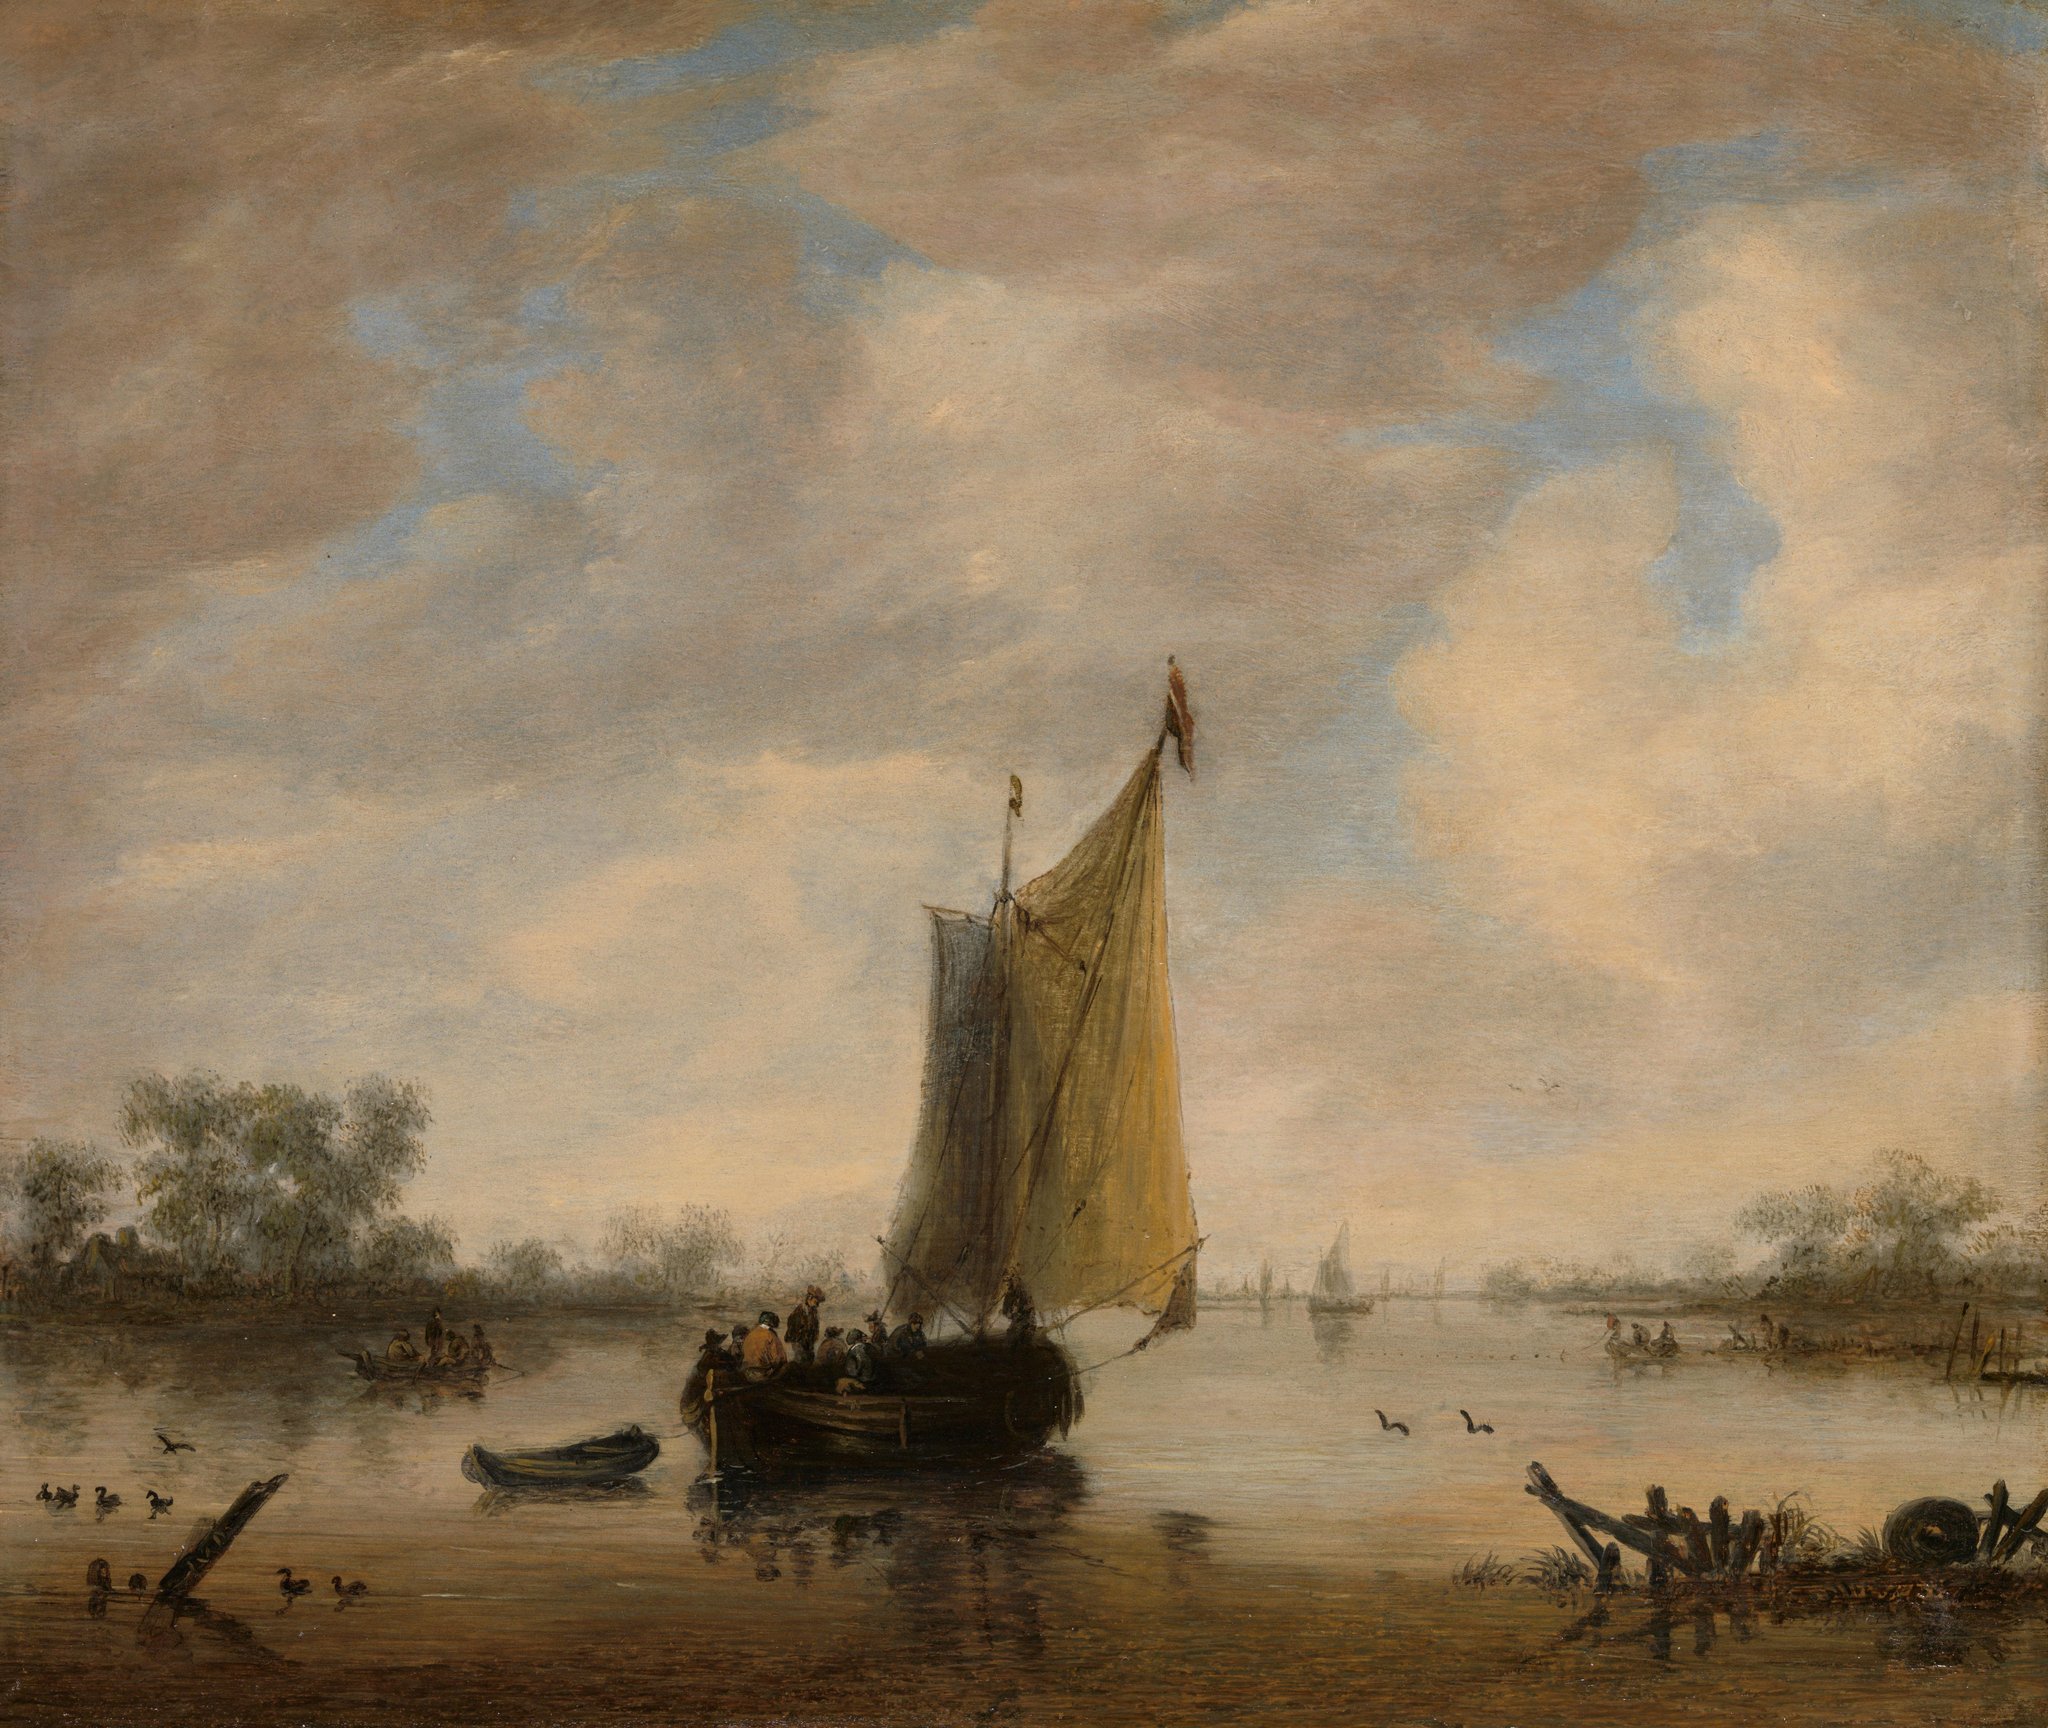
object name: painting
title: River View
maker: jeronymus van diest (ii)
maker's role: painter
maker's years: 1631-1677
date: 1650-1675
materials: oil, panel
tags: ferry, river (+ landscape with figures, staffage)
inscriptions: signature: ‘I.V.D.’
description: Riviergezicht. Op het water een veerpont met mensen en enkele roeibootjes.